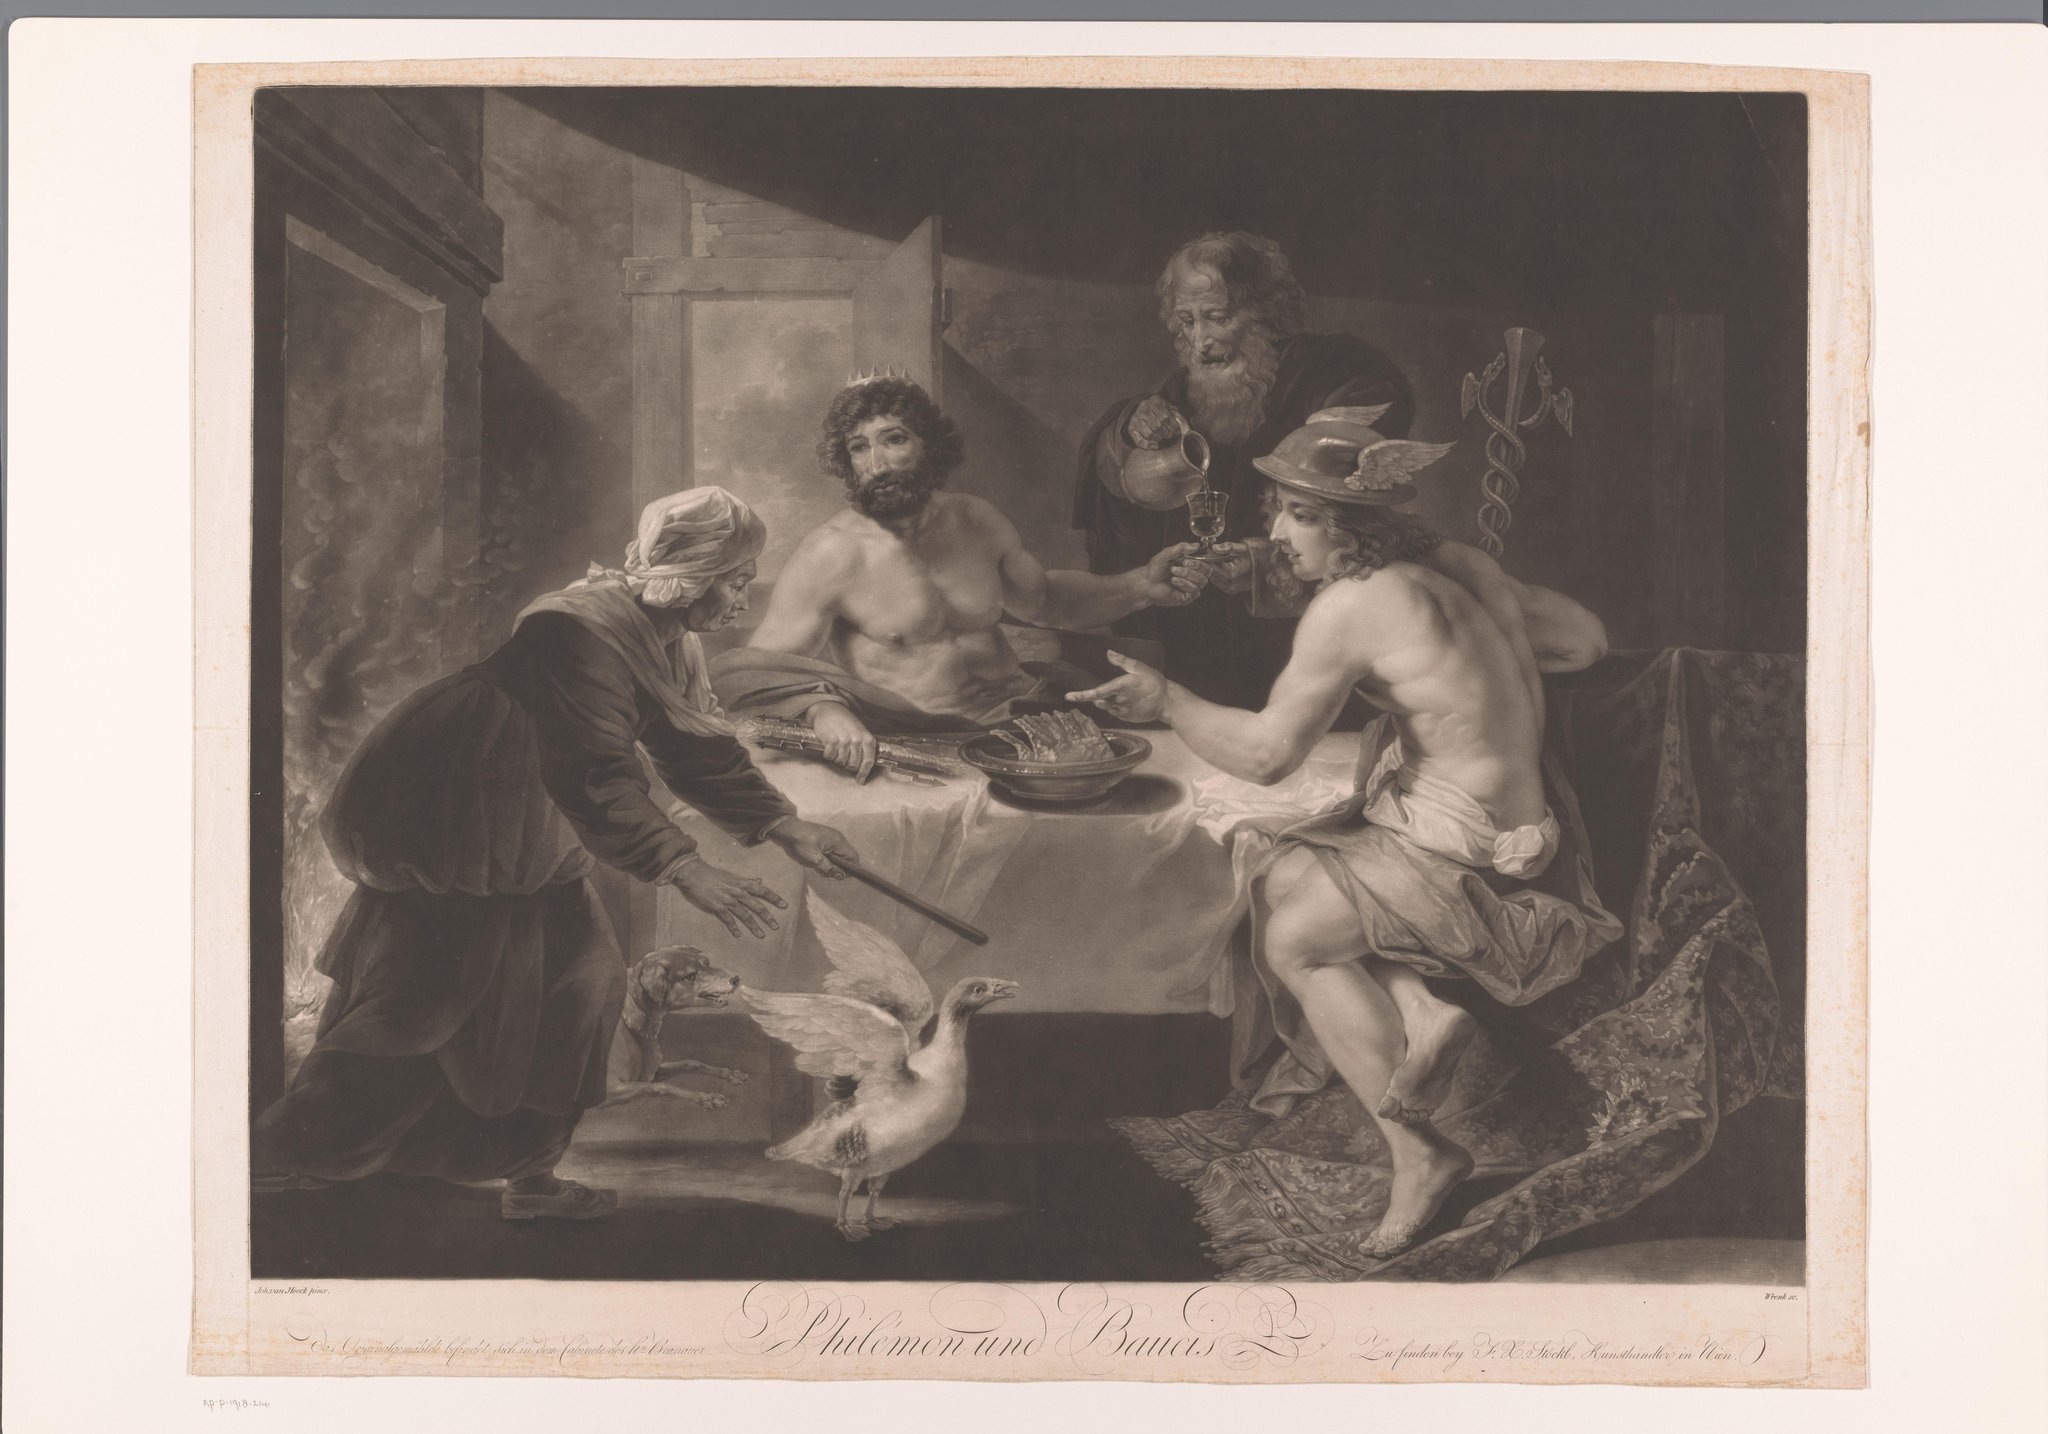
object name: print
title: Philémon und Baucis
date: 1776-1830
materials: paper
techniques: mezzotint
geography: vienna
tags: philemon and his wife baucis hospitably entertain jupiter and mercury in travellers' guise; possibly a goose, which they try to kill for the occasion, flies to the visitors for refuge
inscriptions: collector's mark: Lugt 2233